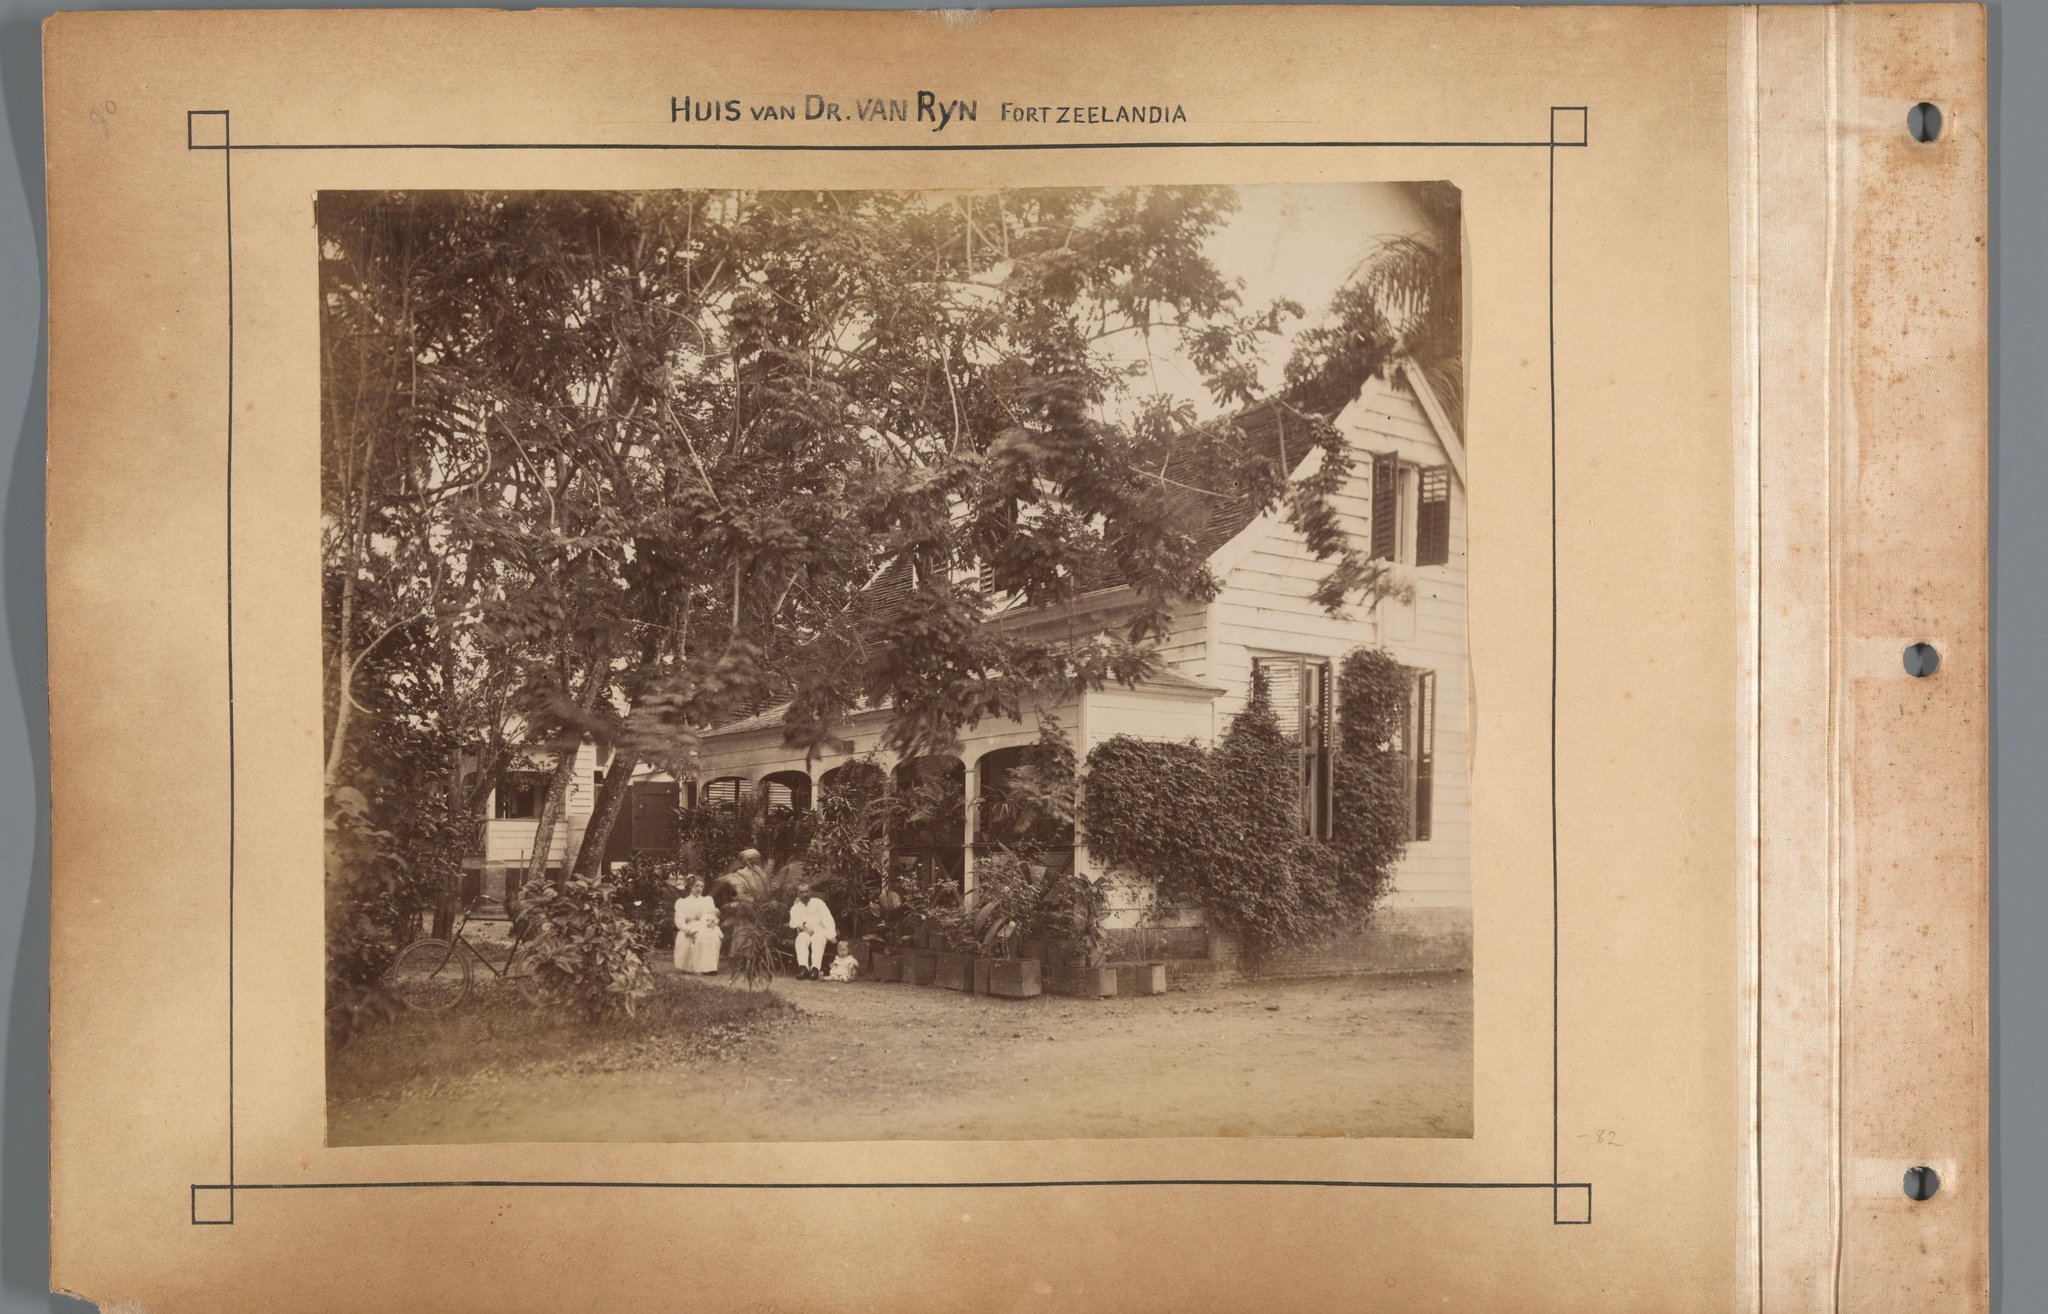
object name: photograph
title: Huis van Dr. van Ryn, Fort Zeelandia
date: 1898-1902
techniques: albumen print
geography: suriname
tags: suriname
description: Het huis van Dr. van Ryn, Fort Zeelandia in Paramaribo.